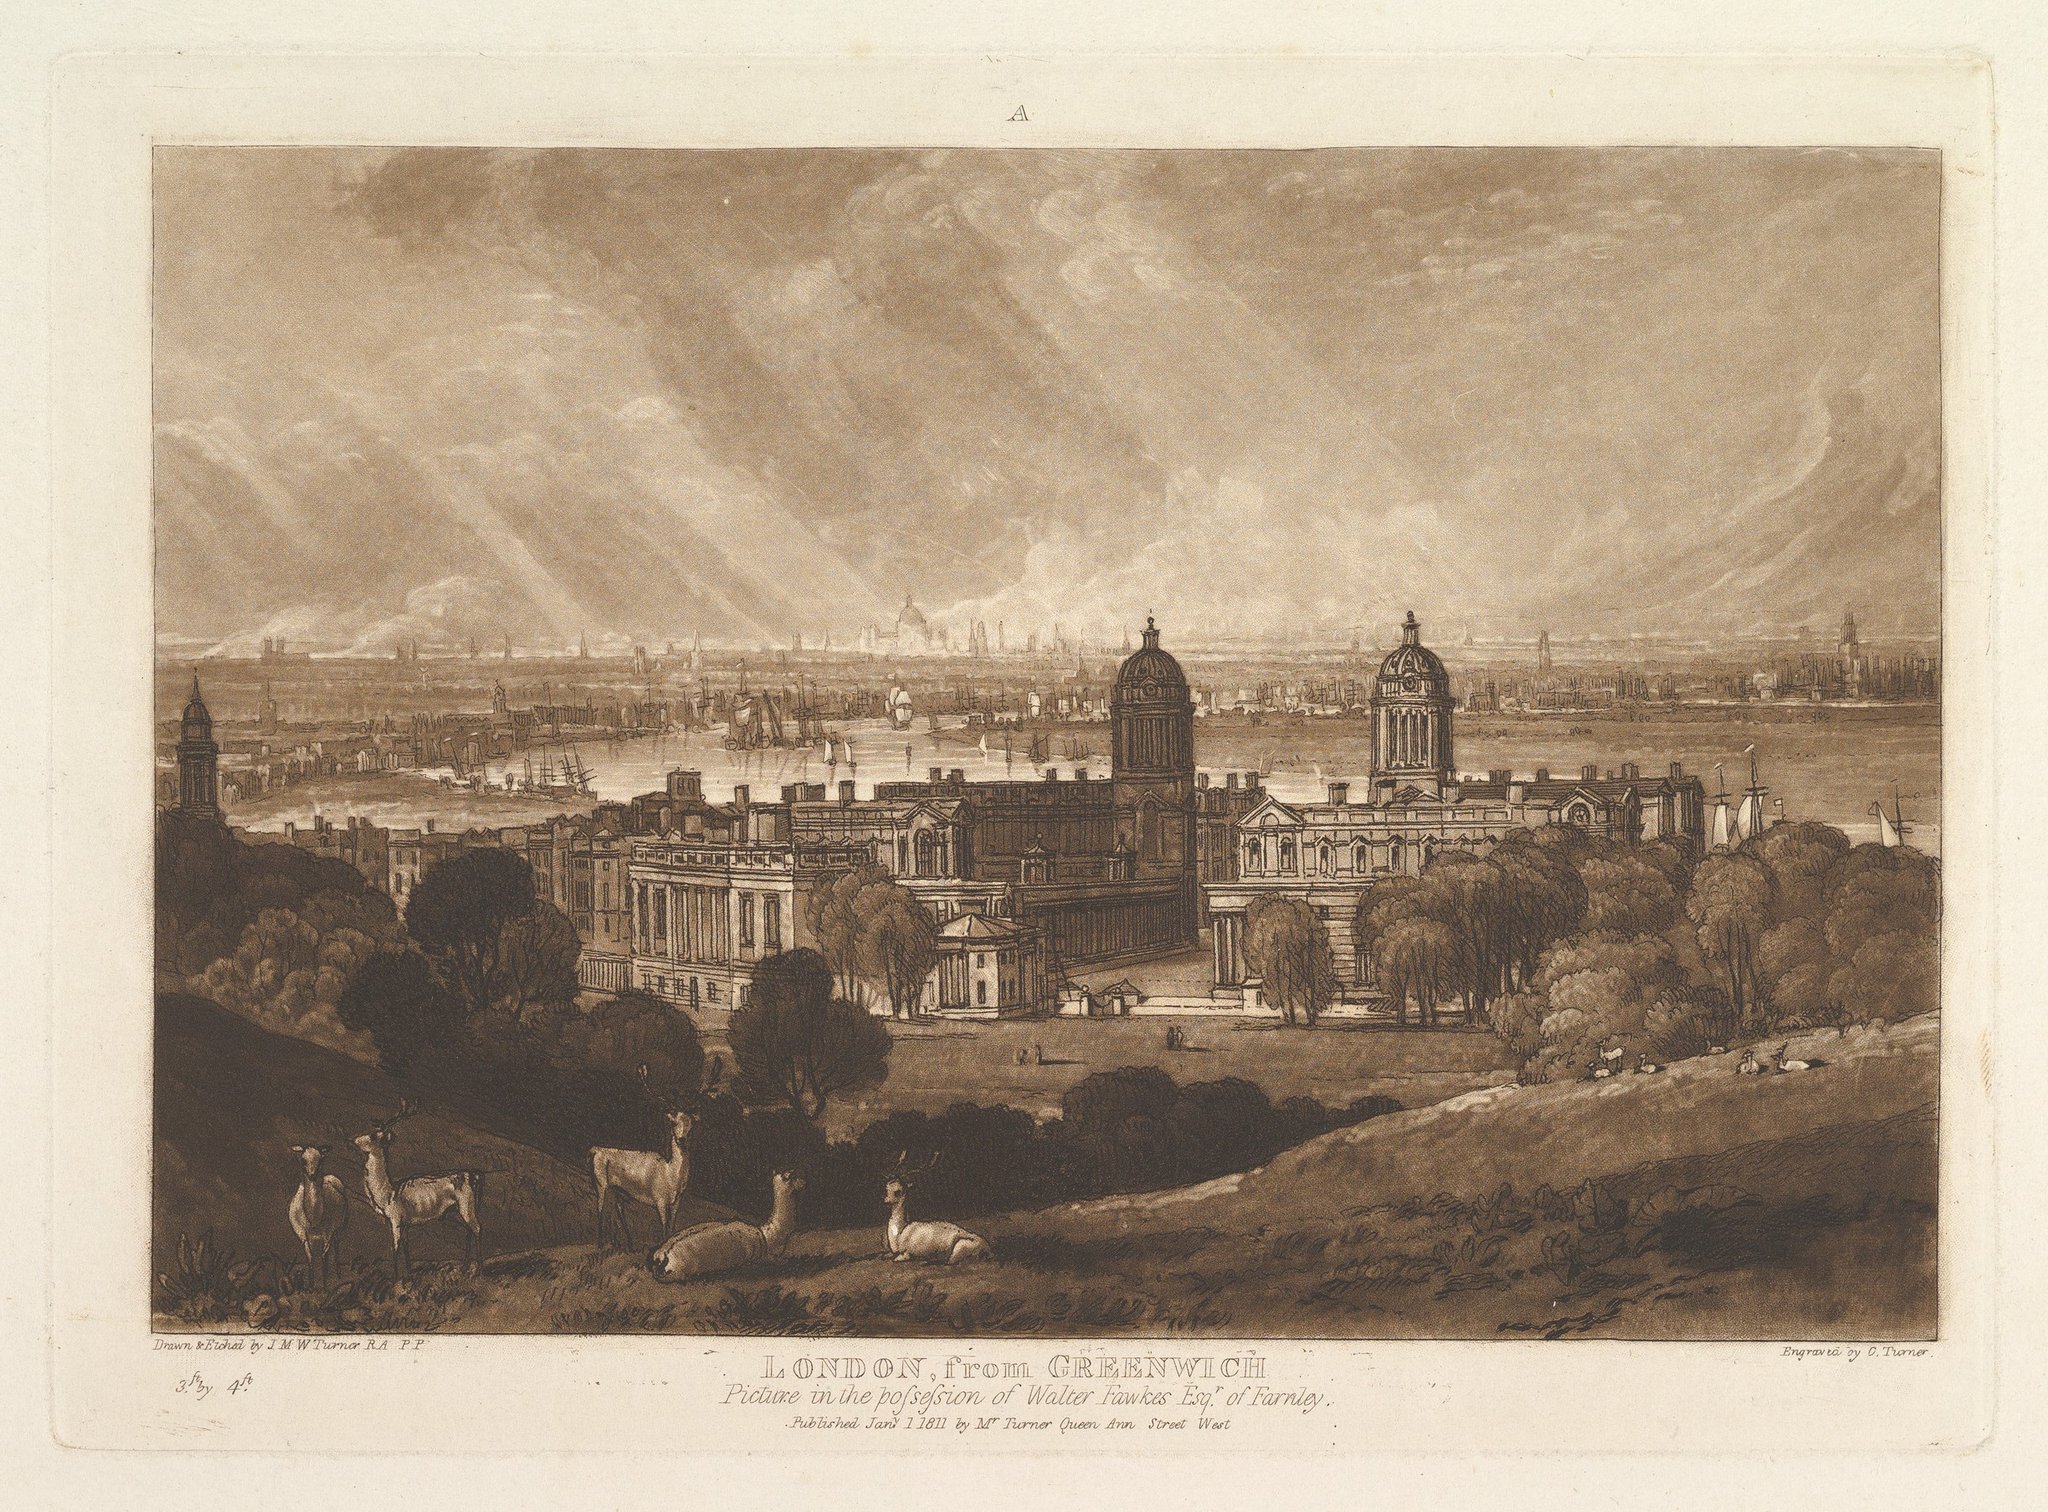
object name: print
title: London from Greenwich, part V, plate 26 from "Liber Studiorum"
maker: joseph mallord william turner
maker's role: artist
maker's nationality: british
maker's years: 1775-1851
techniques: etching, mezzotint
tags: buildings,cities,london